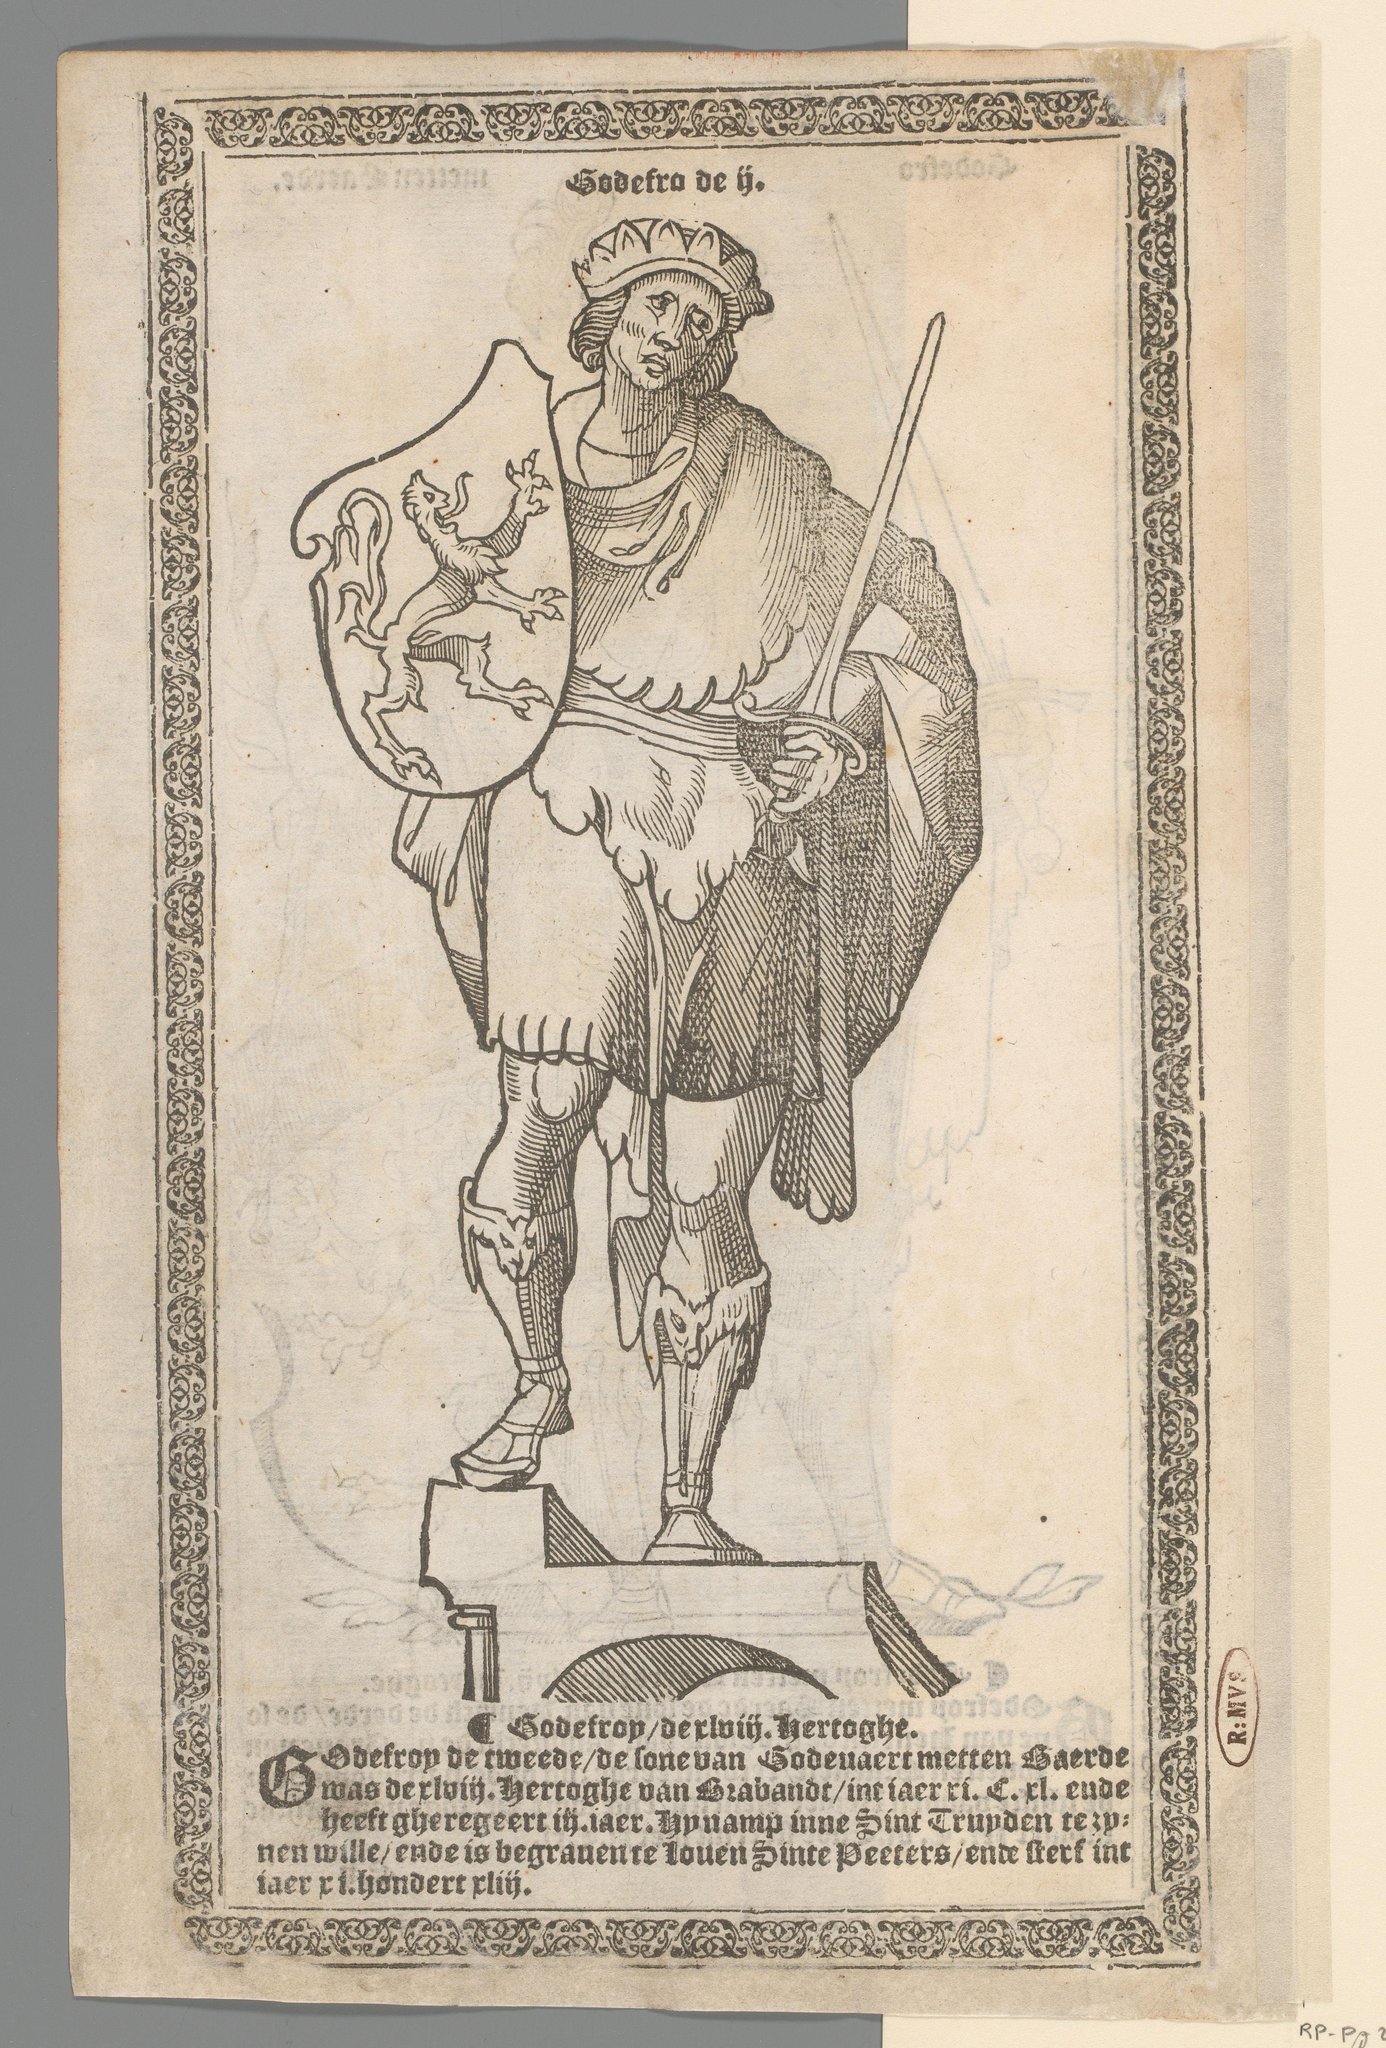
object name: book illustration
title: Portret van Godfried II van Leuven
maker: jan molijns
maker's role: print maker, publisher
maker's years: 1498-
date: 1565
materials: paper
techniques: letterpress printing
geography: antwerp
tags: historical persons, hacking and thrusting weapons: sword, armorial bearing, heraldry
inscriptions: collector's mark: Lugt 2228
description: Prent uit: Dit is die afcoemste ende genalogie der hertoghen ende hertoginnen van Brabandt, (...). Antwerpen: Jan Molijns, 1565.